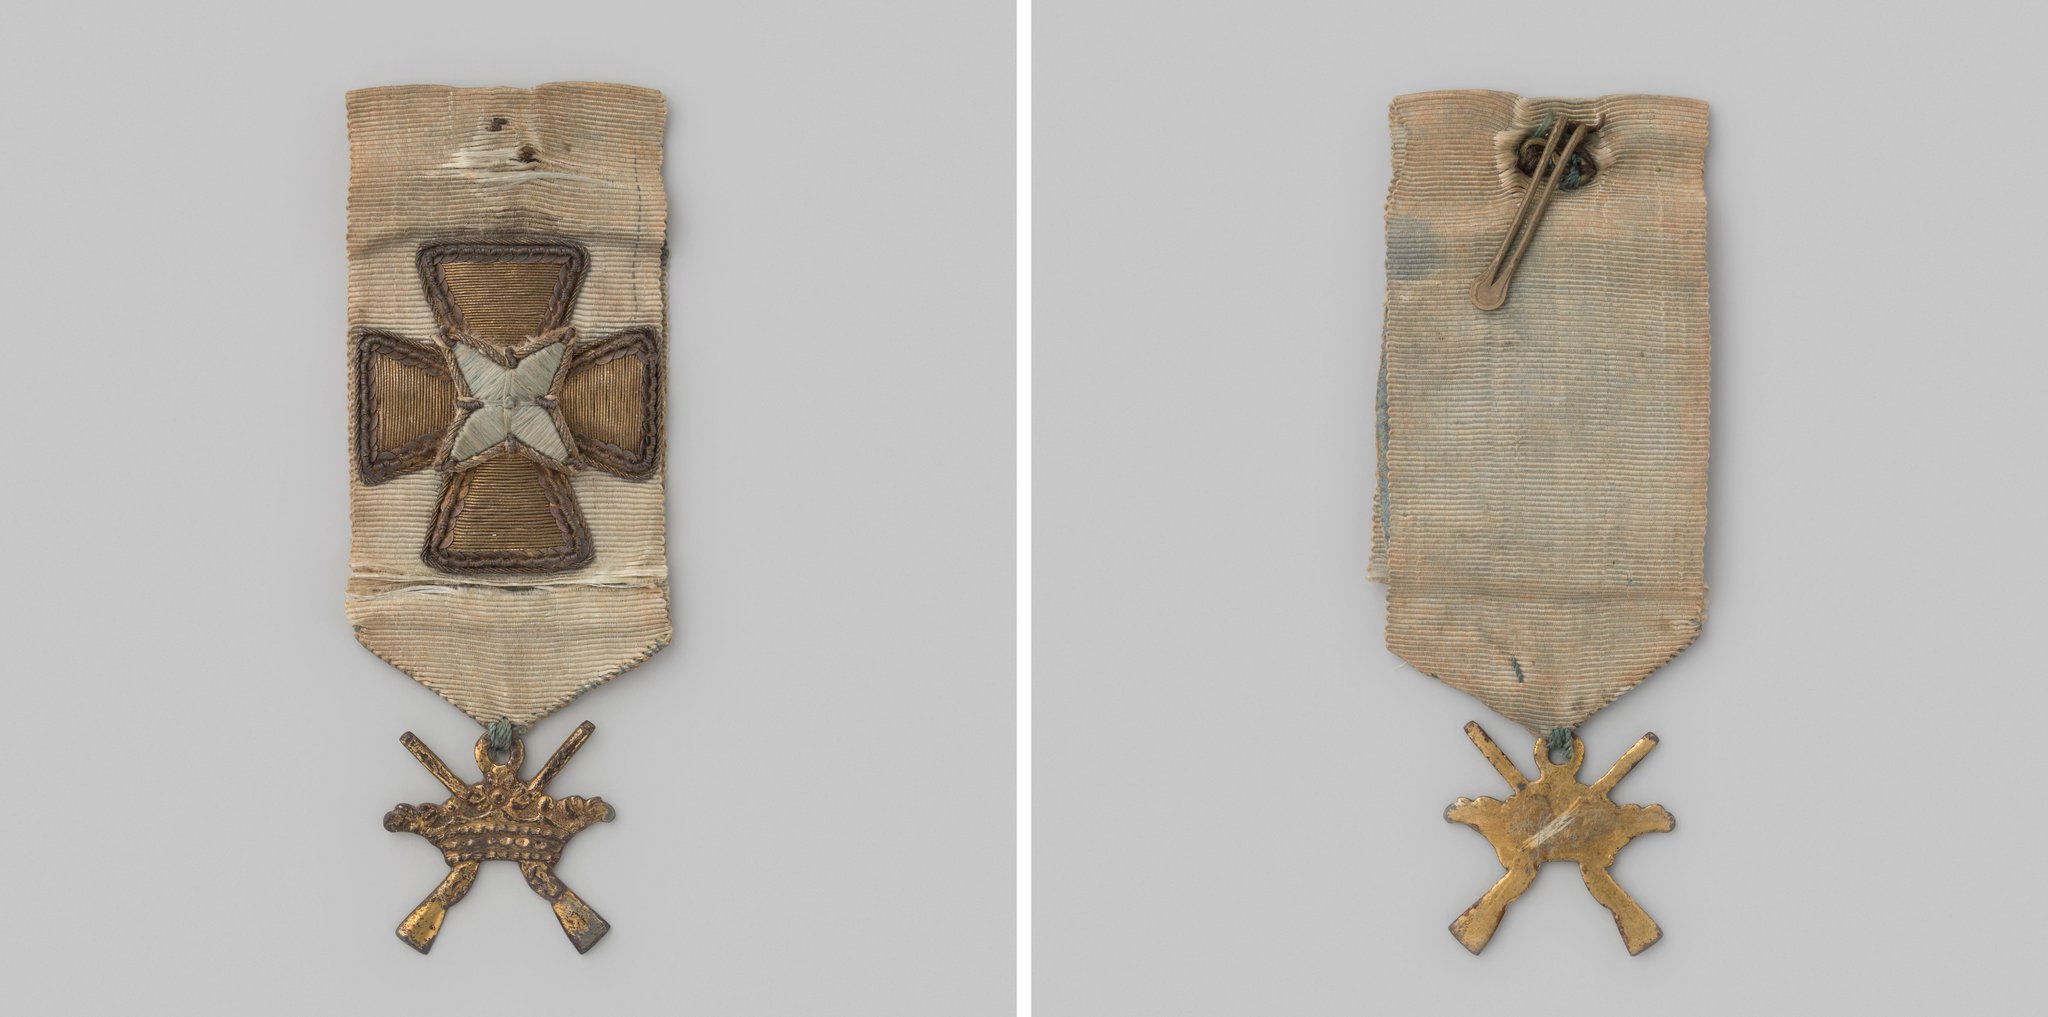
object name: medal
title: Onderscheidingsteken van de schutters van de Ridderlijke Confrerie van de Handbussche te Delft.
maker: Anonymous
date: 1737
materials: gold thread, silver, thread, textile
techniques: gilding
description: Verguld zilveren draagteken met oog, waaraan een geribd zijden lint met borduursel van goud- en zilverdraad.